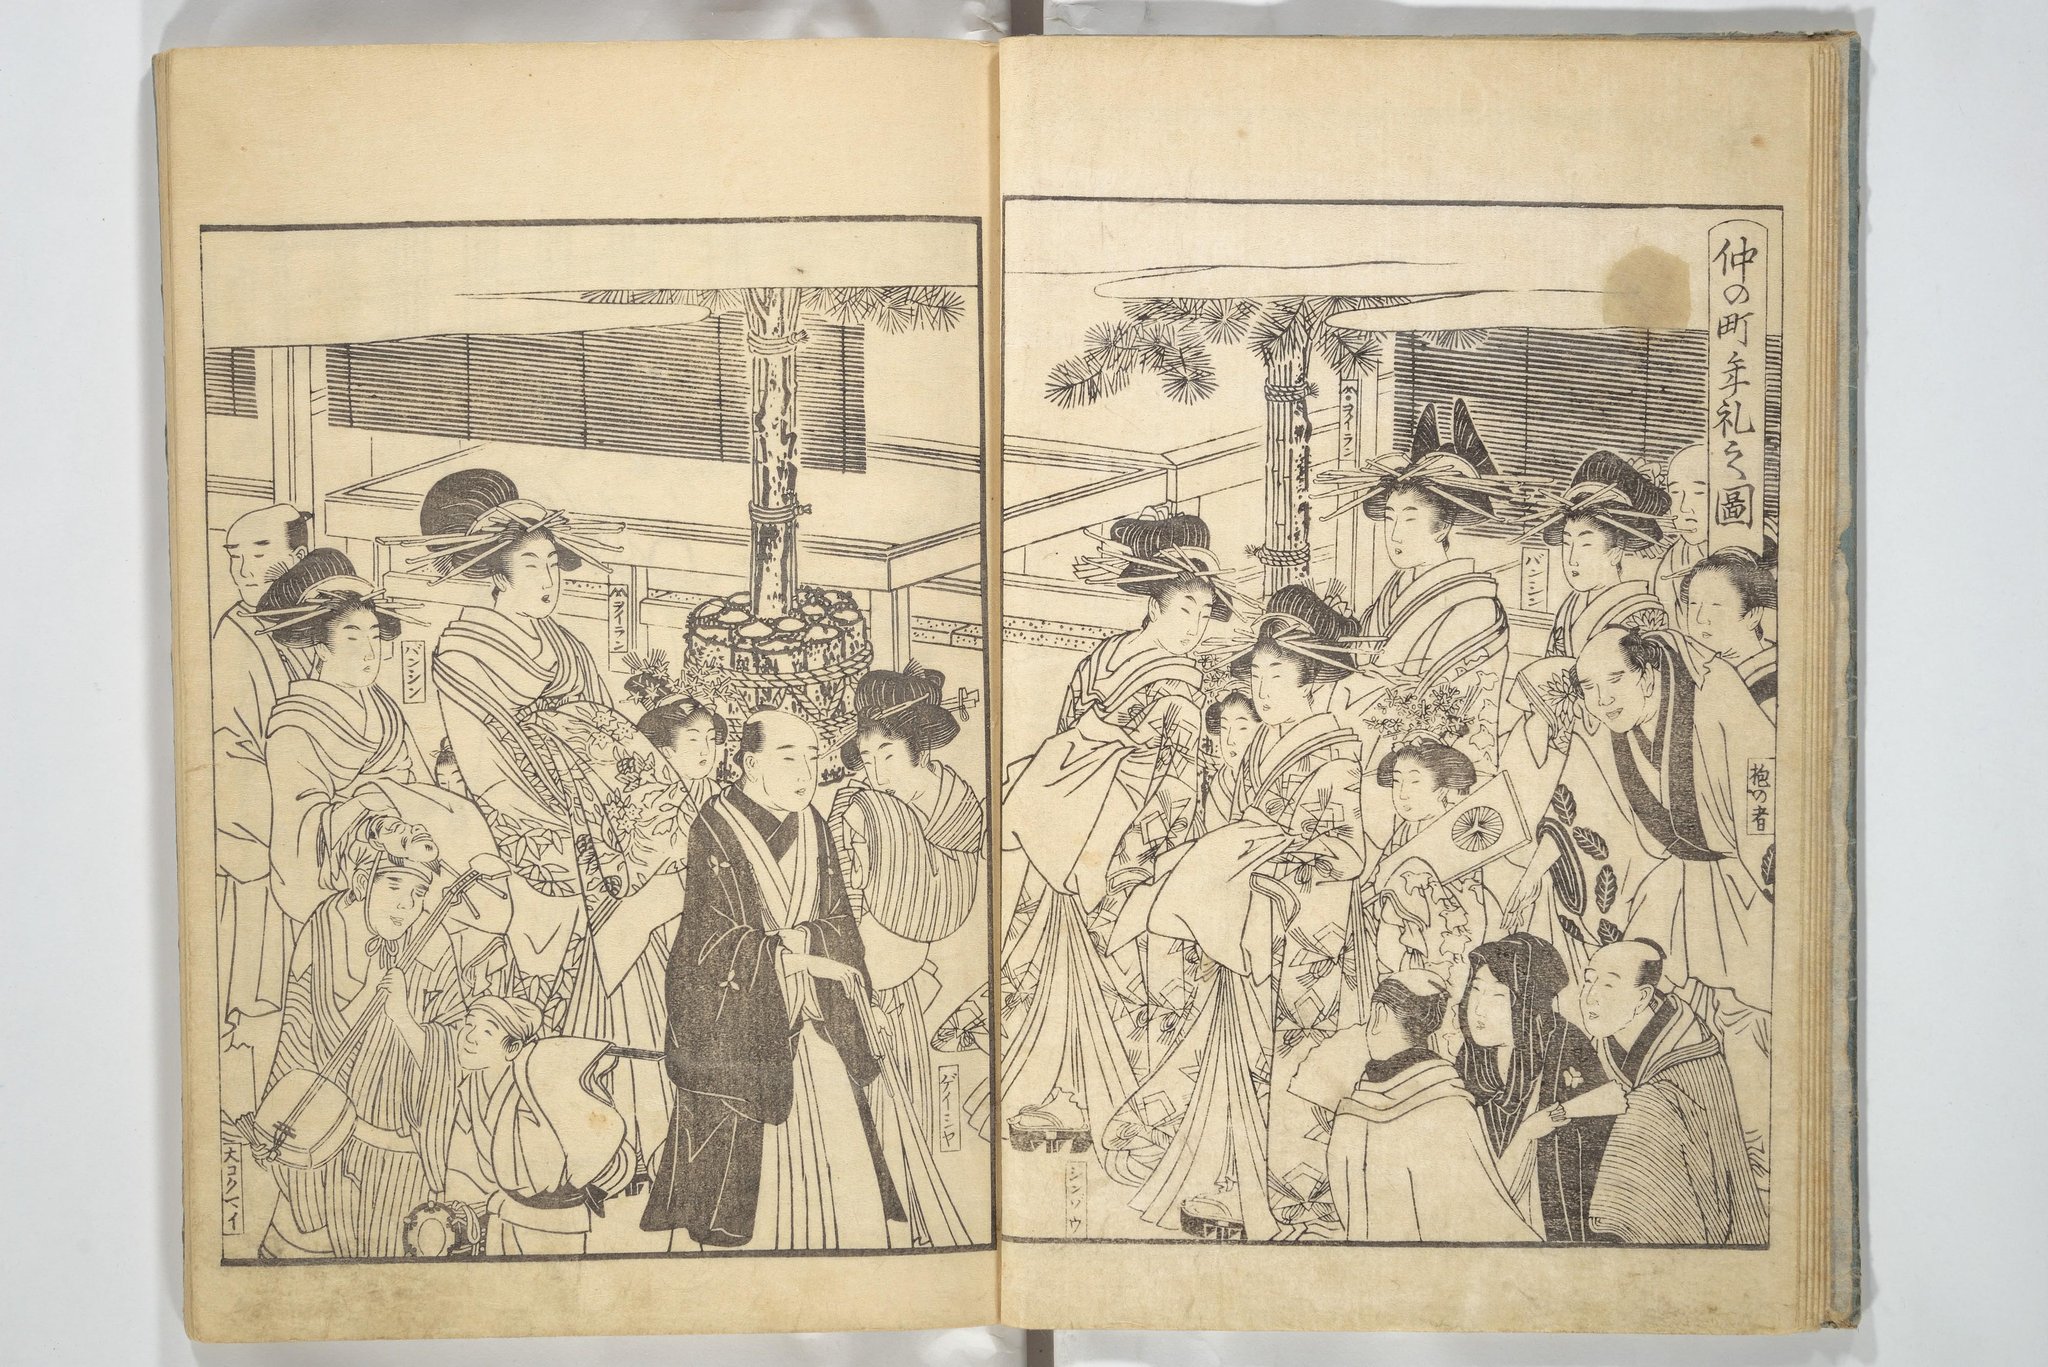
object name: illustrated book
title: Yoshiwara Picture Book of New Year’s Festivities (Seirō ehon nenjū gyōji) 青楼繪本年中行事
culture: japanese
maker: kitagawa utamaro 喜多川歌麿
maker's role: artist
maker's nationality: japanese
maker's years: 1754-1806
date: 1804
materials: ink, paper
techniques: woodblock print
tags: musical instruments,men,women